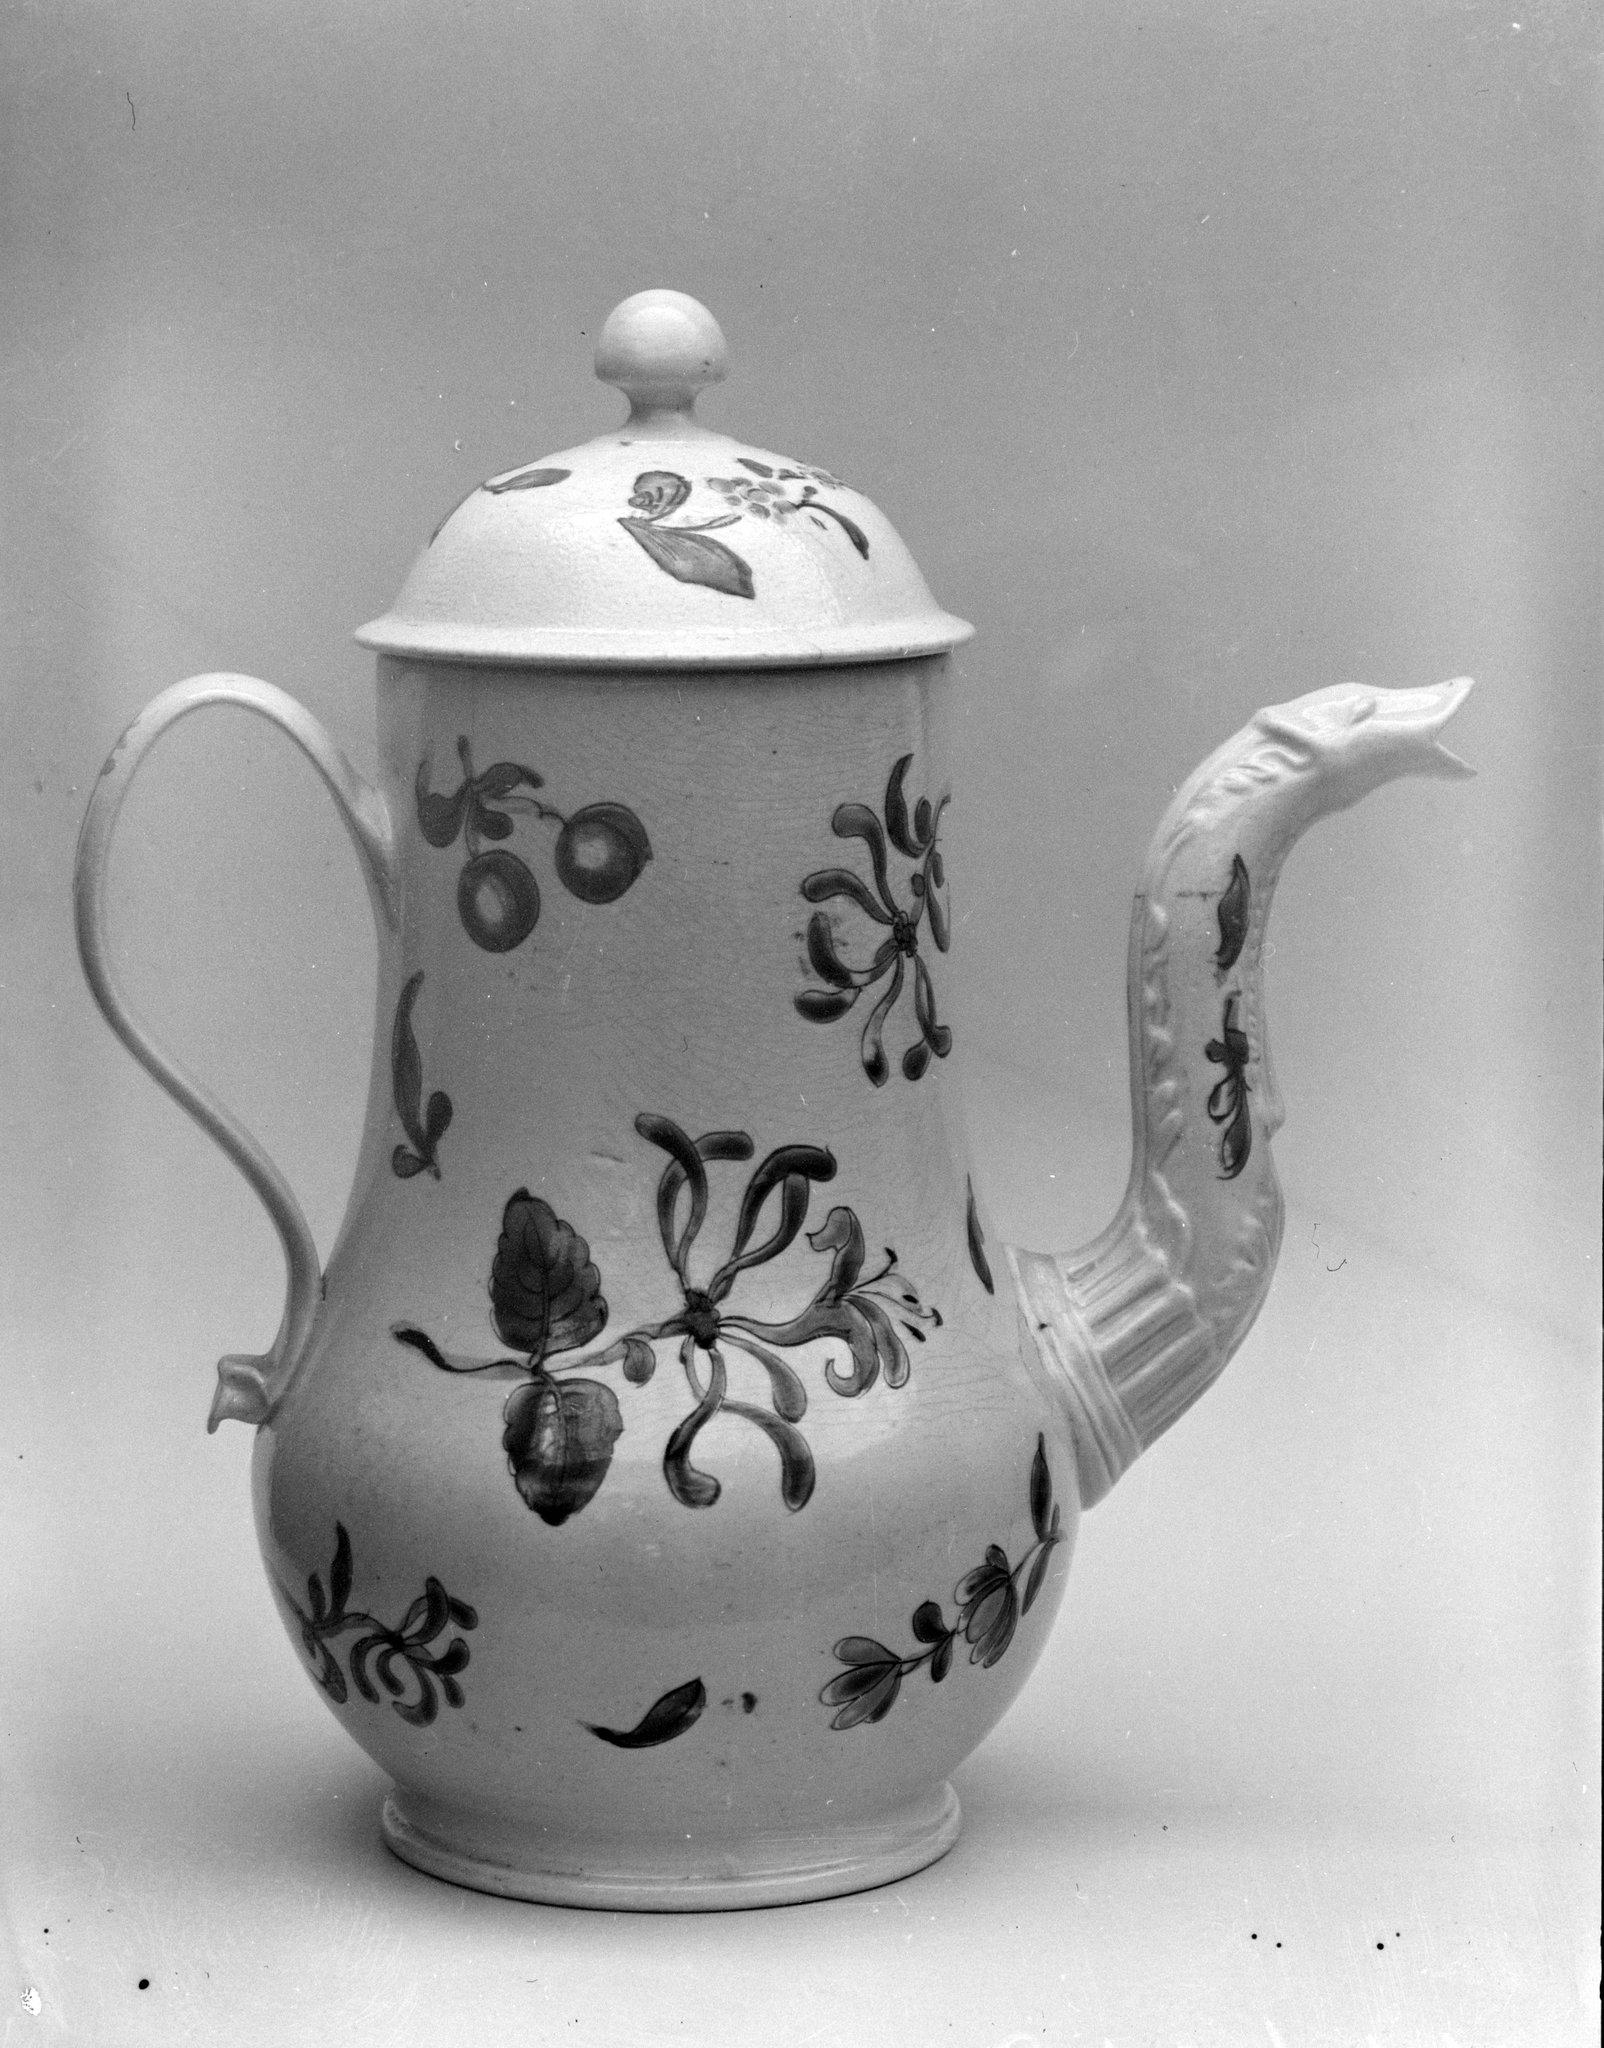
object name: coffeepot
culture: british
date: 1760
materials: stoneware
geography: england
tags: flowers